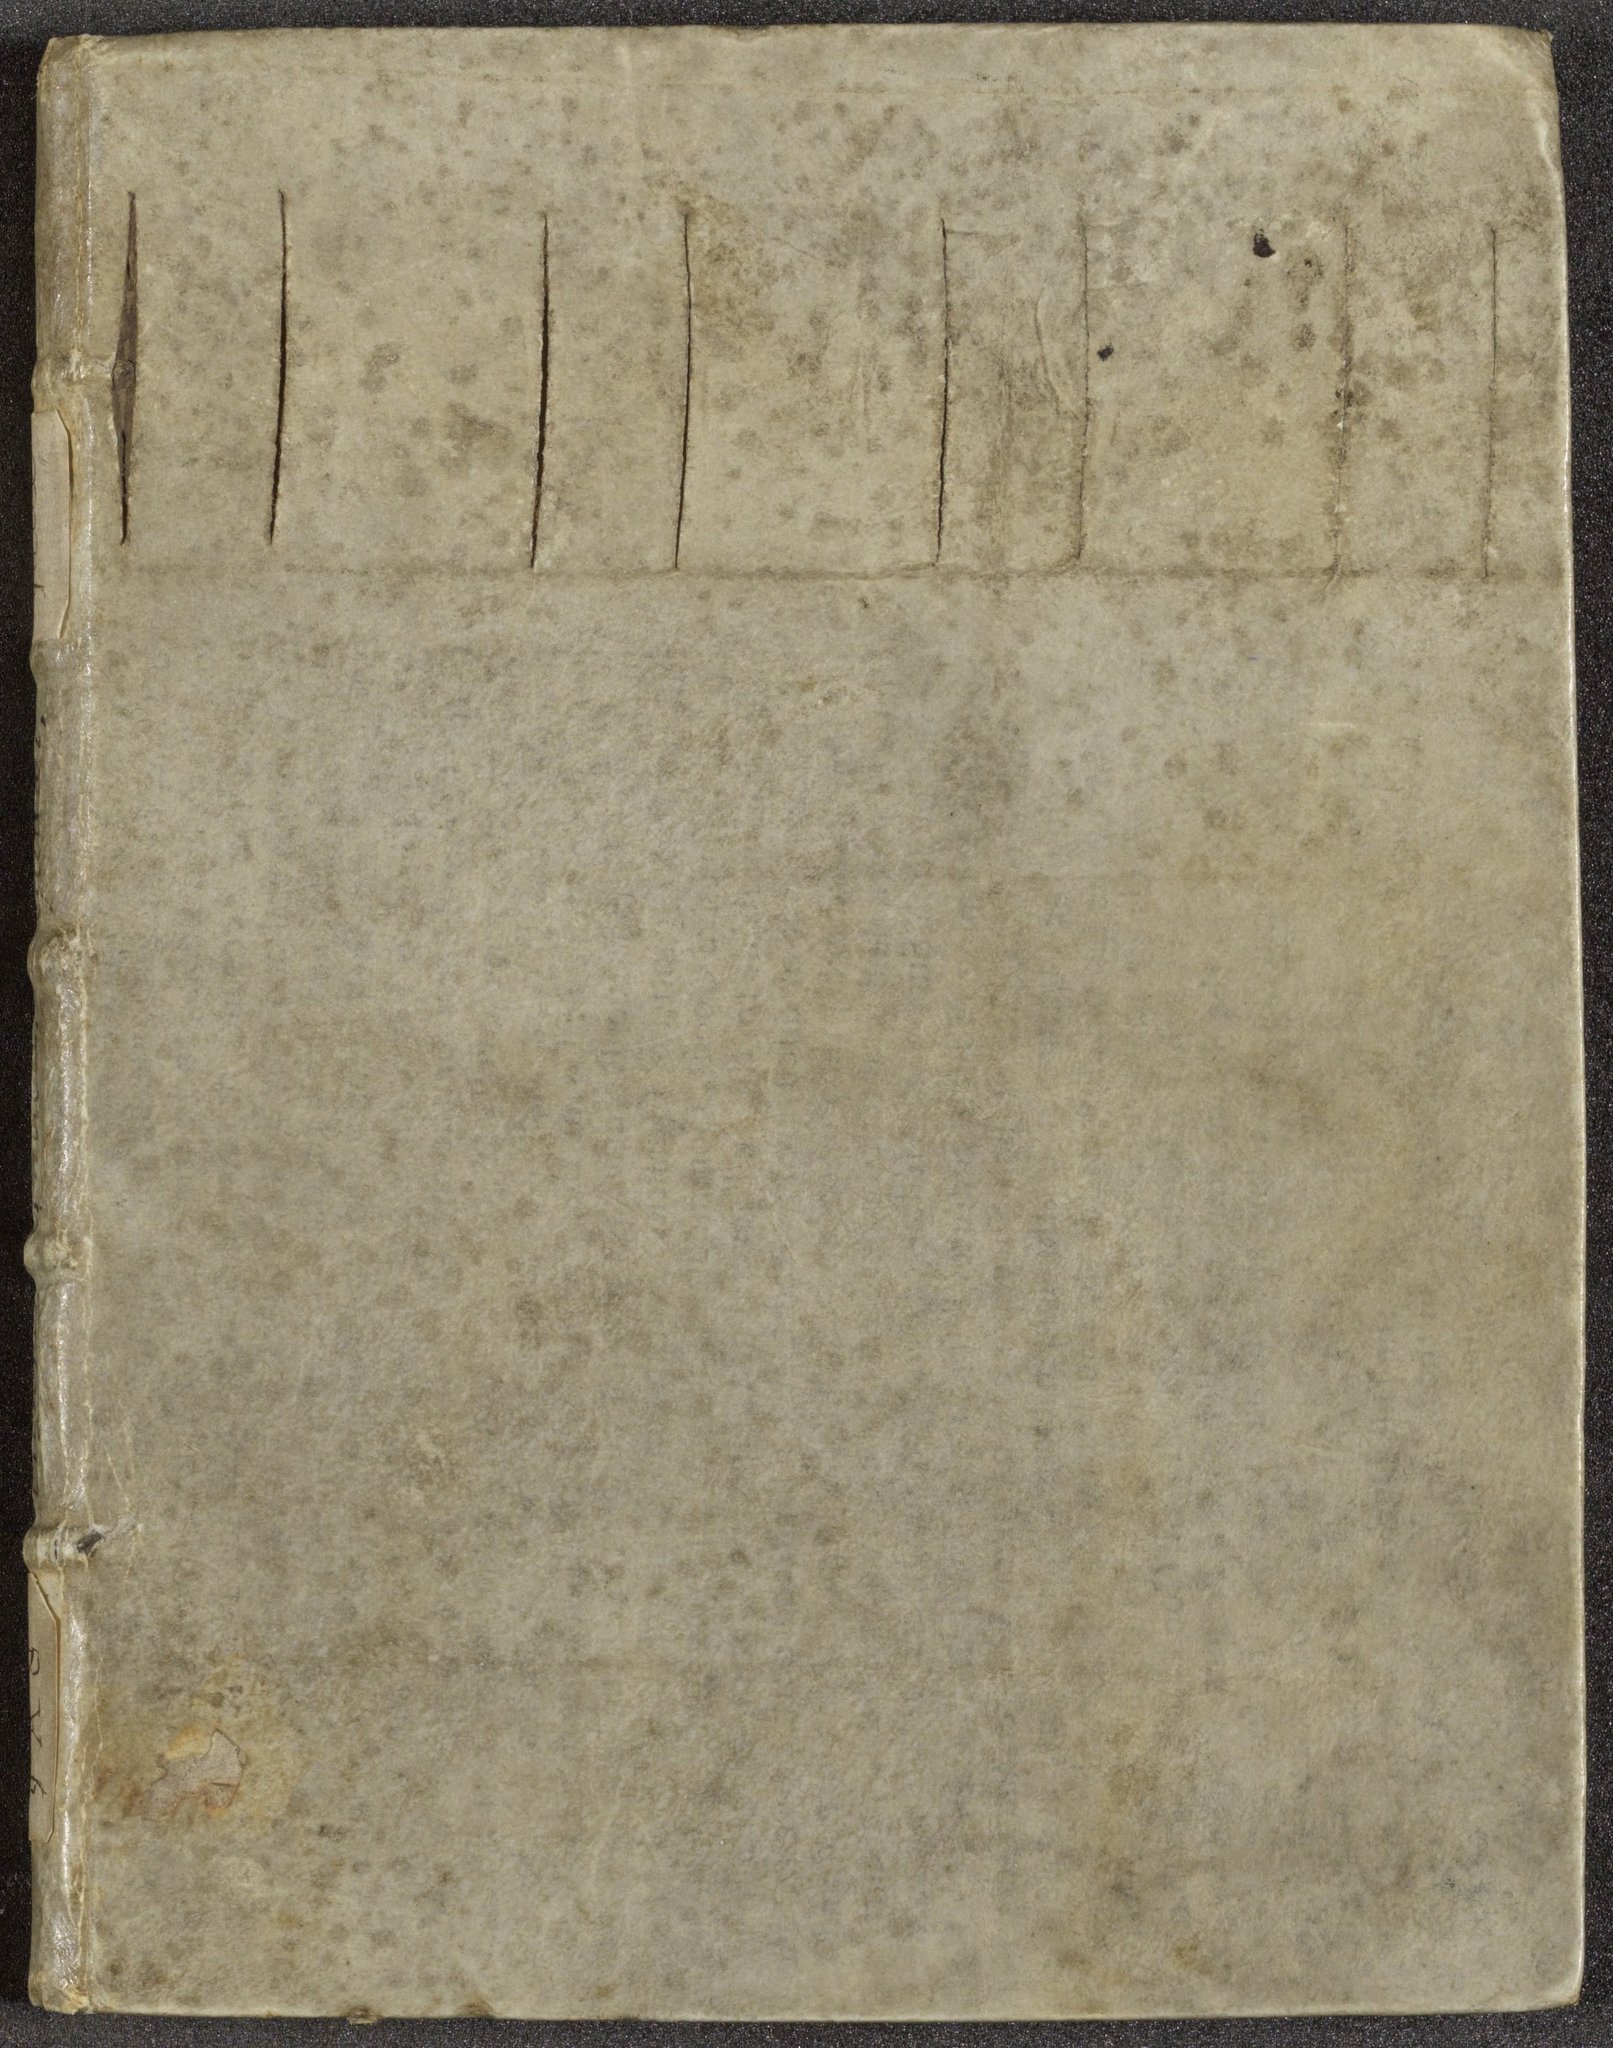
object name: prentrecueil, prentenalbum, prentalbum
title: Album met personificaties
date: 1585-1590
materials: paper, parchment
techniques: engraving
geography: antwerp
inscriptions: label: ‘9 A 8 / Galle’, collector's mark: Lugt 2228, collector's mark: Lugt 2760, inscription: ‘9 A 8’, inscription: ‘c32955’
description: Album met 45 gravures op 49 albumbladen. Het album bevat de serie met de titel: Prosopographia ... Na een titelprent en dedicatieprent volgen 43 personificaties, de meeste met een religieus karakter. Achterin een nawoord en een Franstalige uitleg. Perkamenten band met voorin en achterin enkele schutbladen.